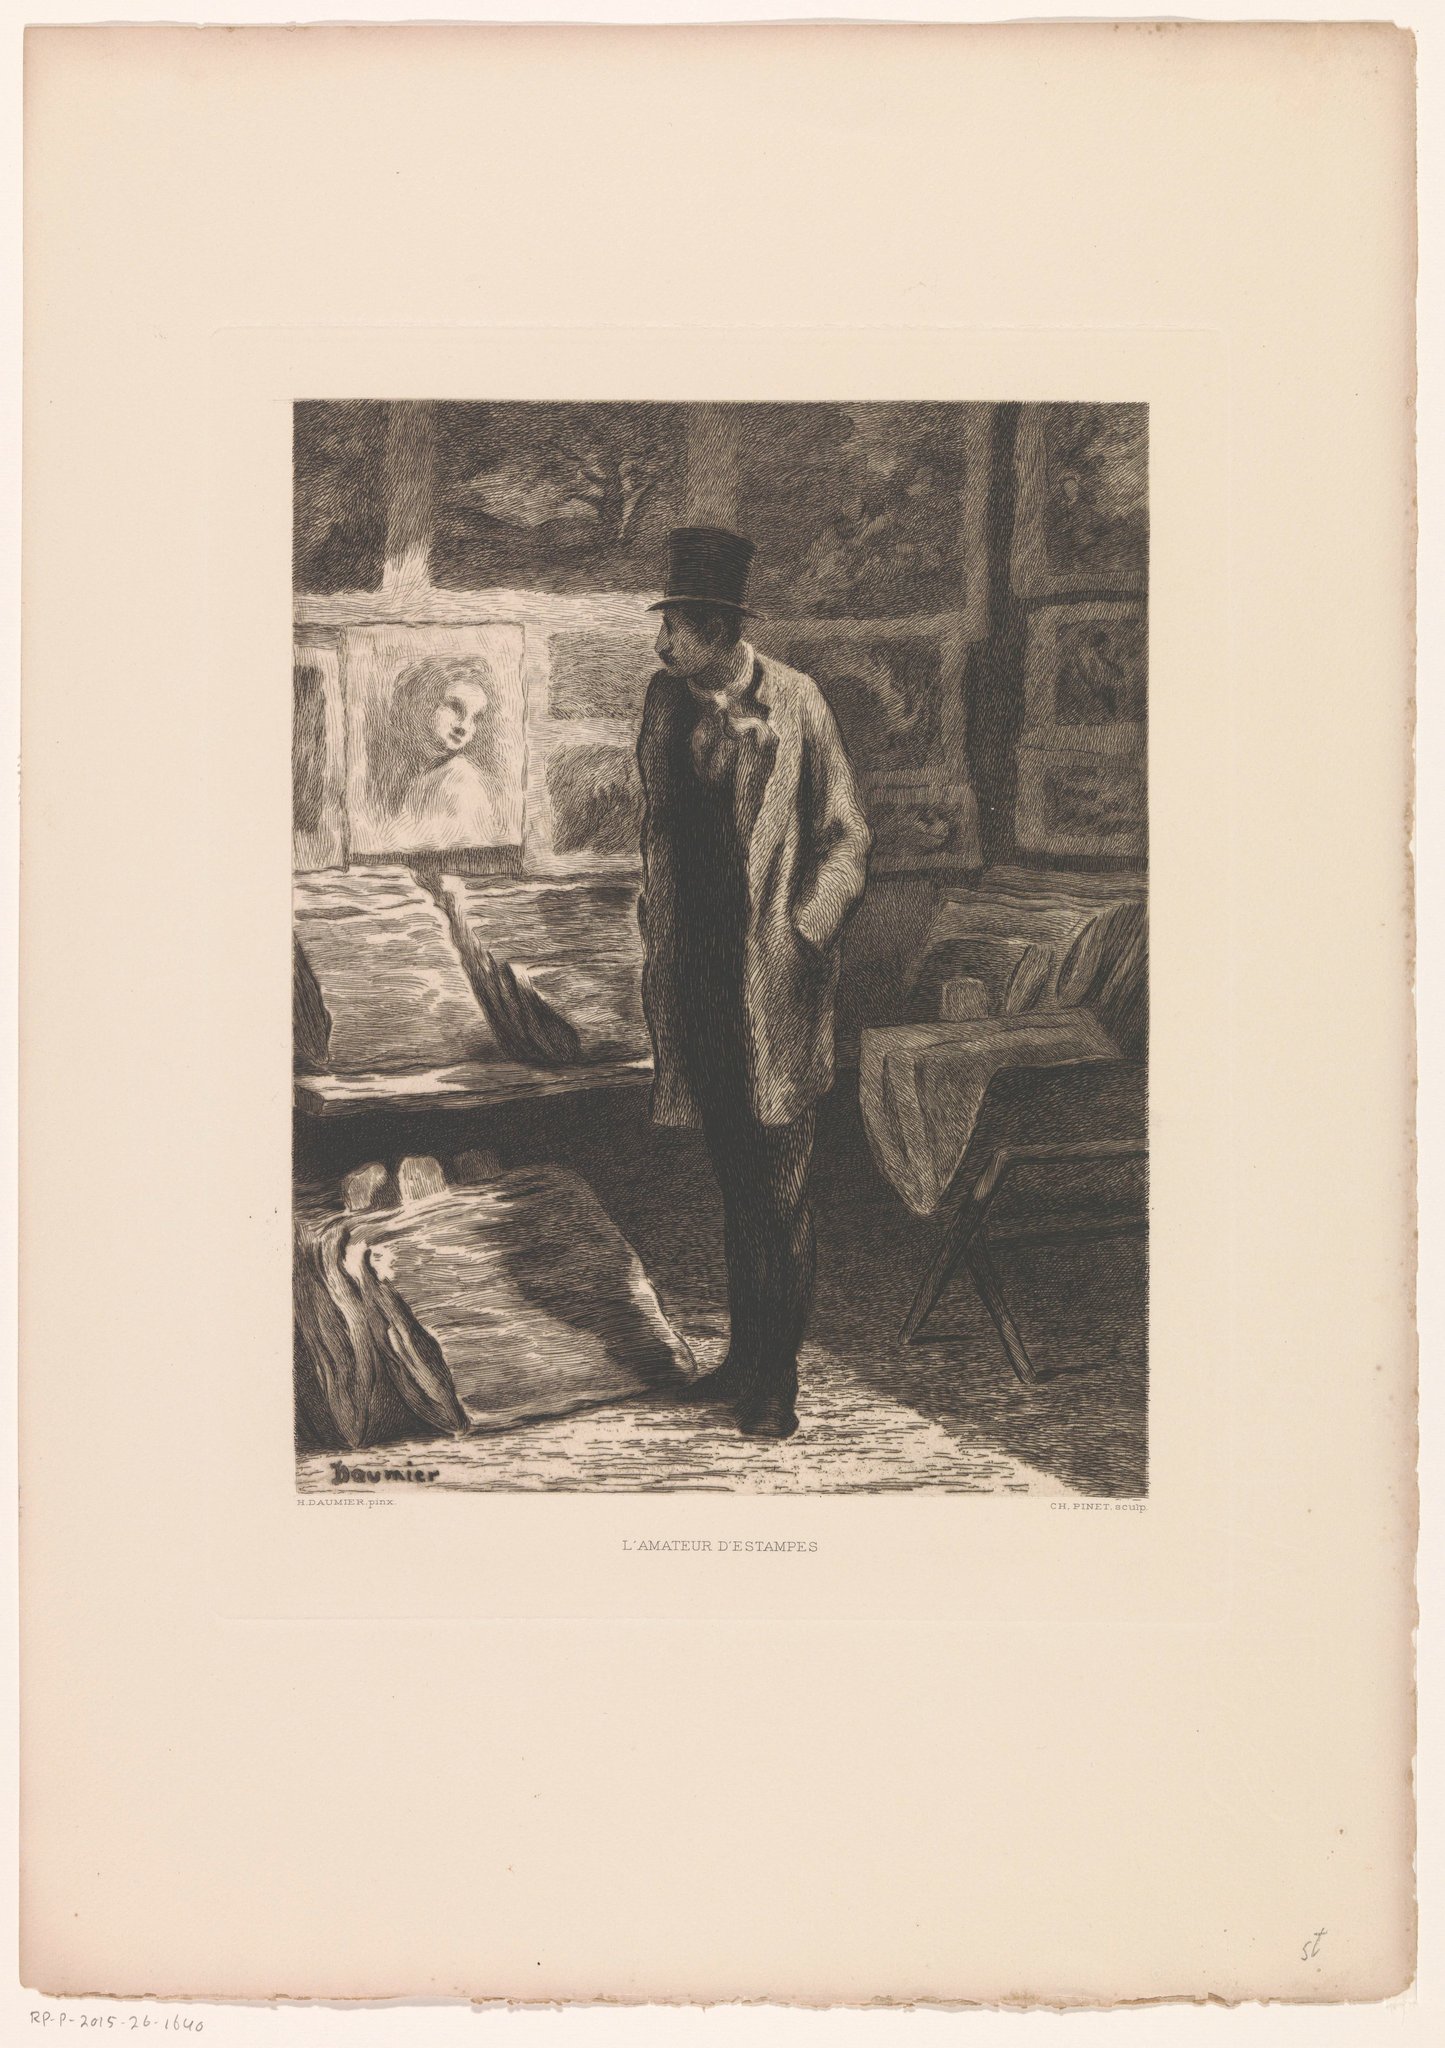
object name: print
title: Verzamelaar van prenten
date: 1877-1932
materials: paper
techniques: etching, intaglio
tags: print, e.g.: engraving, etching, lithograph, art collector (+ graphic arts)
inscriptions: collector's mark: Lugt 4779, collector's mark: Lugt 2228, watermark: ‘RIVES’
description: In de kraam van een prenthandelaar staat een man met een hoge hoed en zijn handen in de zakken van zijn jas. De prenten hangen aan de muur en worden bewaard in de portfolio's die in een prentstandaard staan en op tafel liggen.